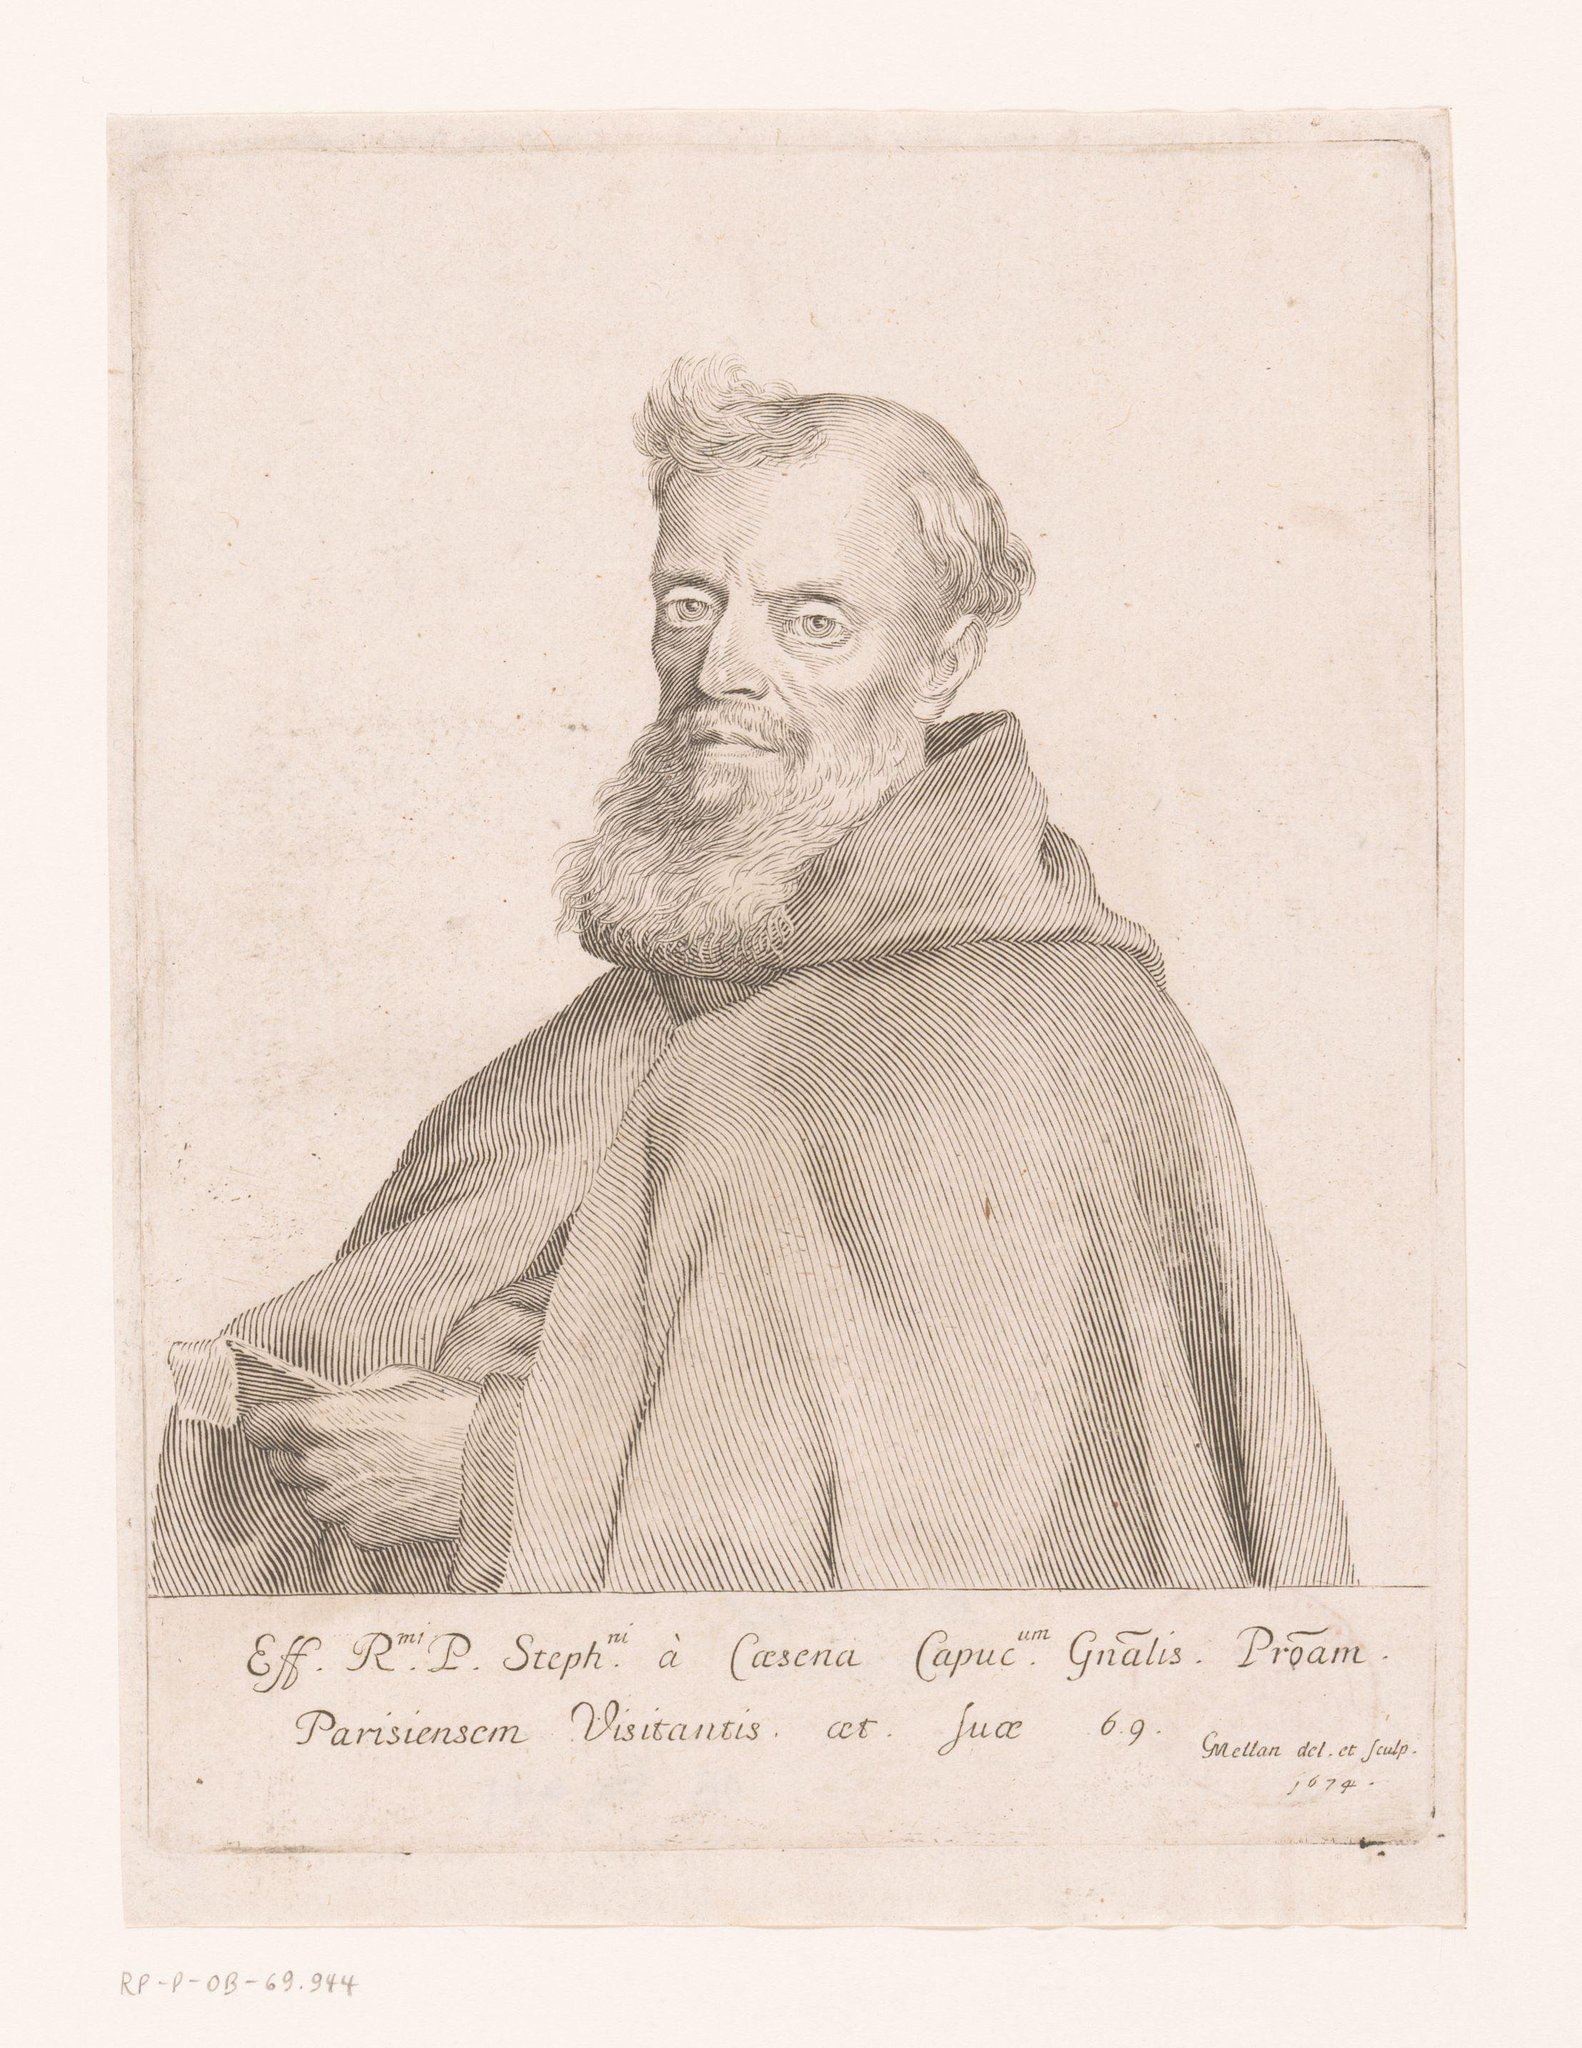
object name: print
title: Portret van Stefano da Cesena op 69-jarige leeftijd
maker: claude mellan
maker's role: draughtsman, print maker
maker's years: 1598-1688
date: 1674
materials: paper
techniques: engraving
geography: france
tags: clergyman, historical persons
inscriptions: collector's mark: Lugt 240